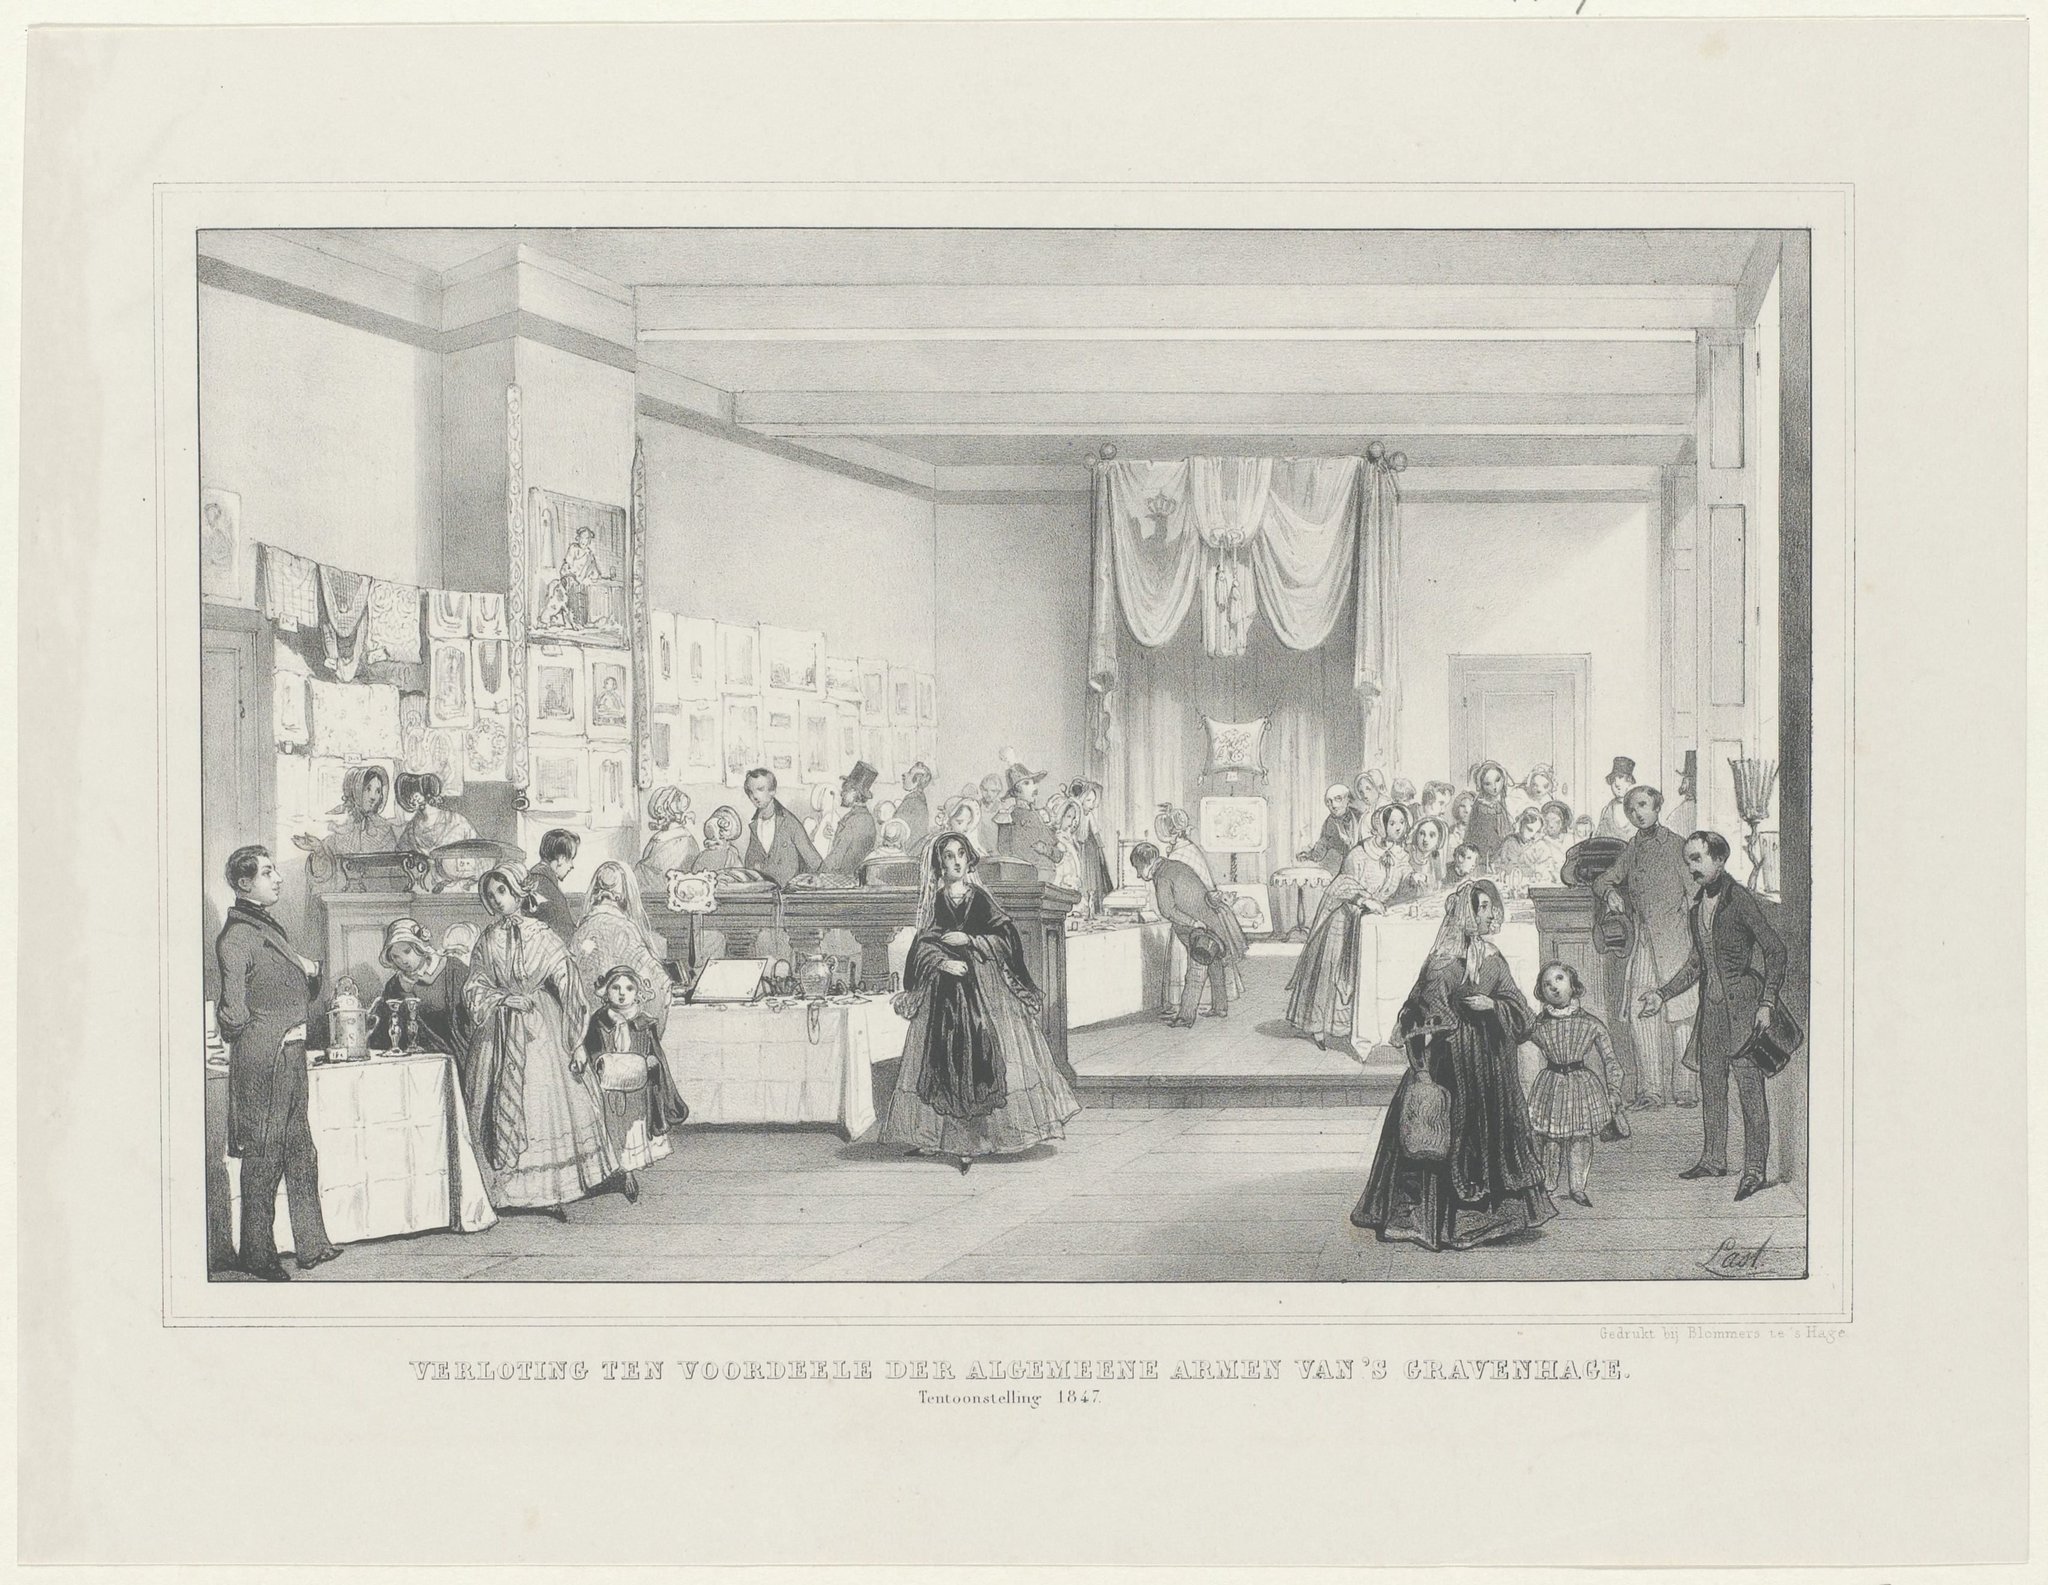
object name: print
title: Verloting ten voordeele der algemeende armen van 's Gravenhage. Tentoonstelling 1847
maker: blommers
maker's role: printer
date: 1847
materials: paper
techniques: lithograph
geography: the hague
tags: raffle, lottery, charitable works, the poor, the hague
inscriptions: collector's mark: Lugt 2228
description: Tentoonstelling van de prijzen te winnen in de loterij ten behoeve van de armen van Den Haag, 1847.